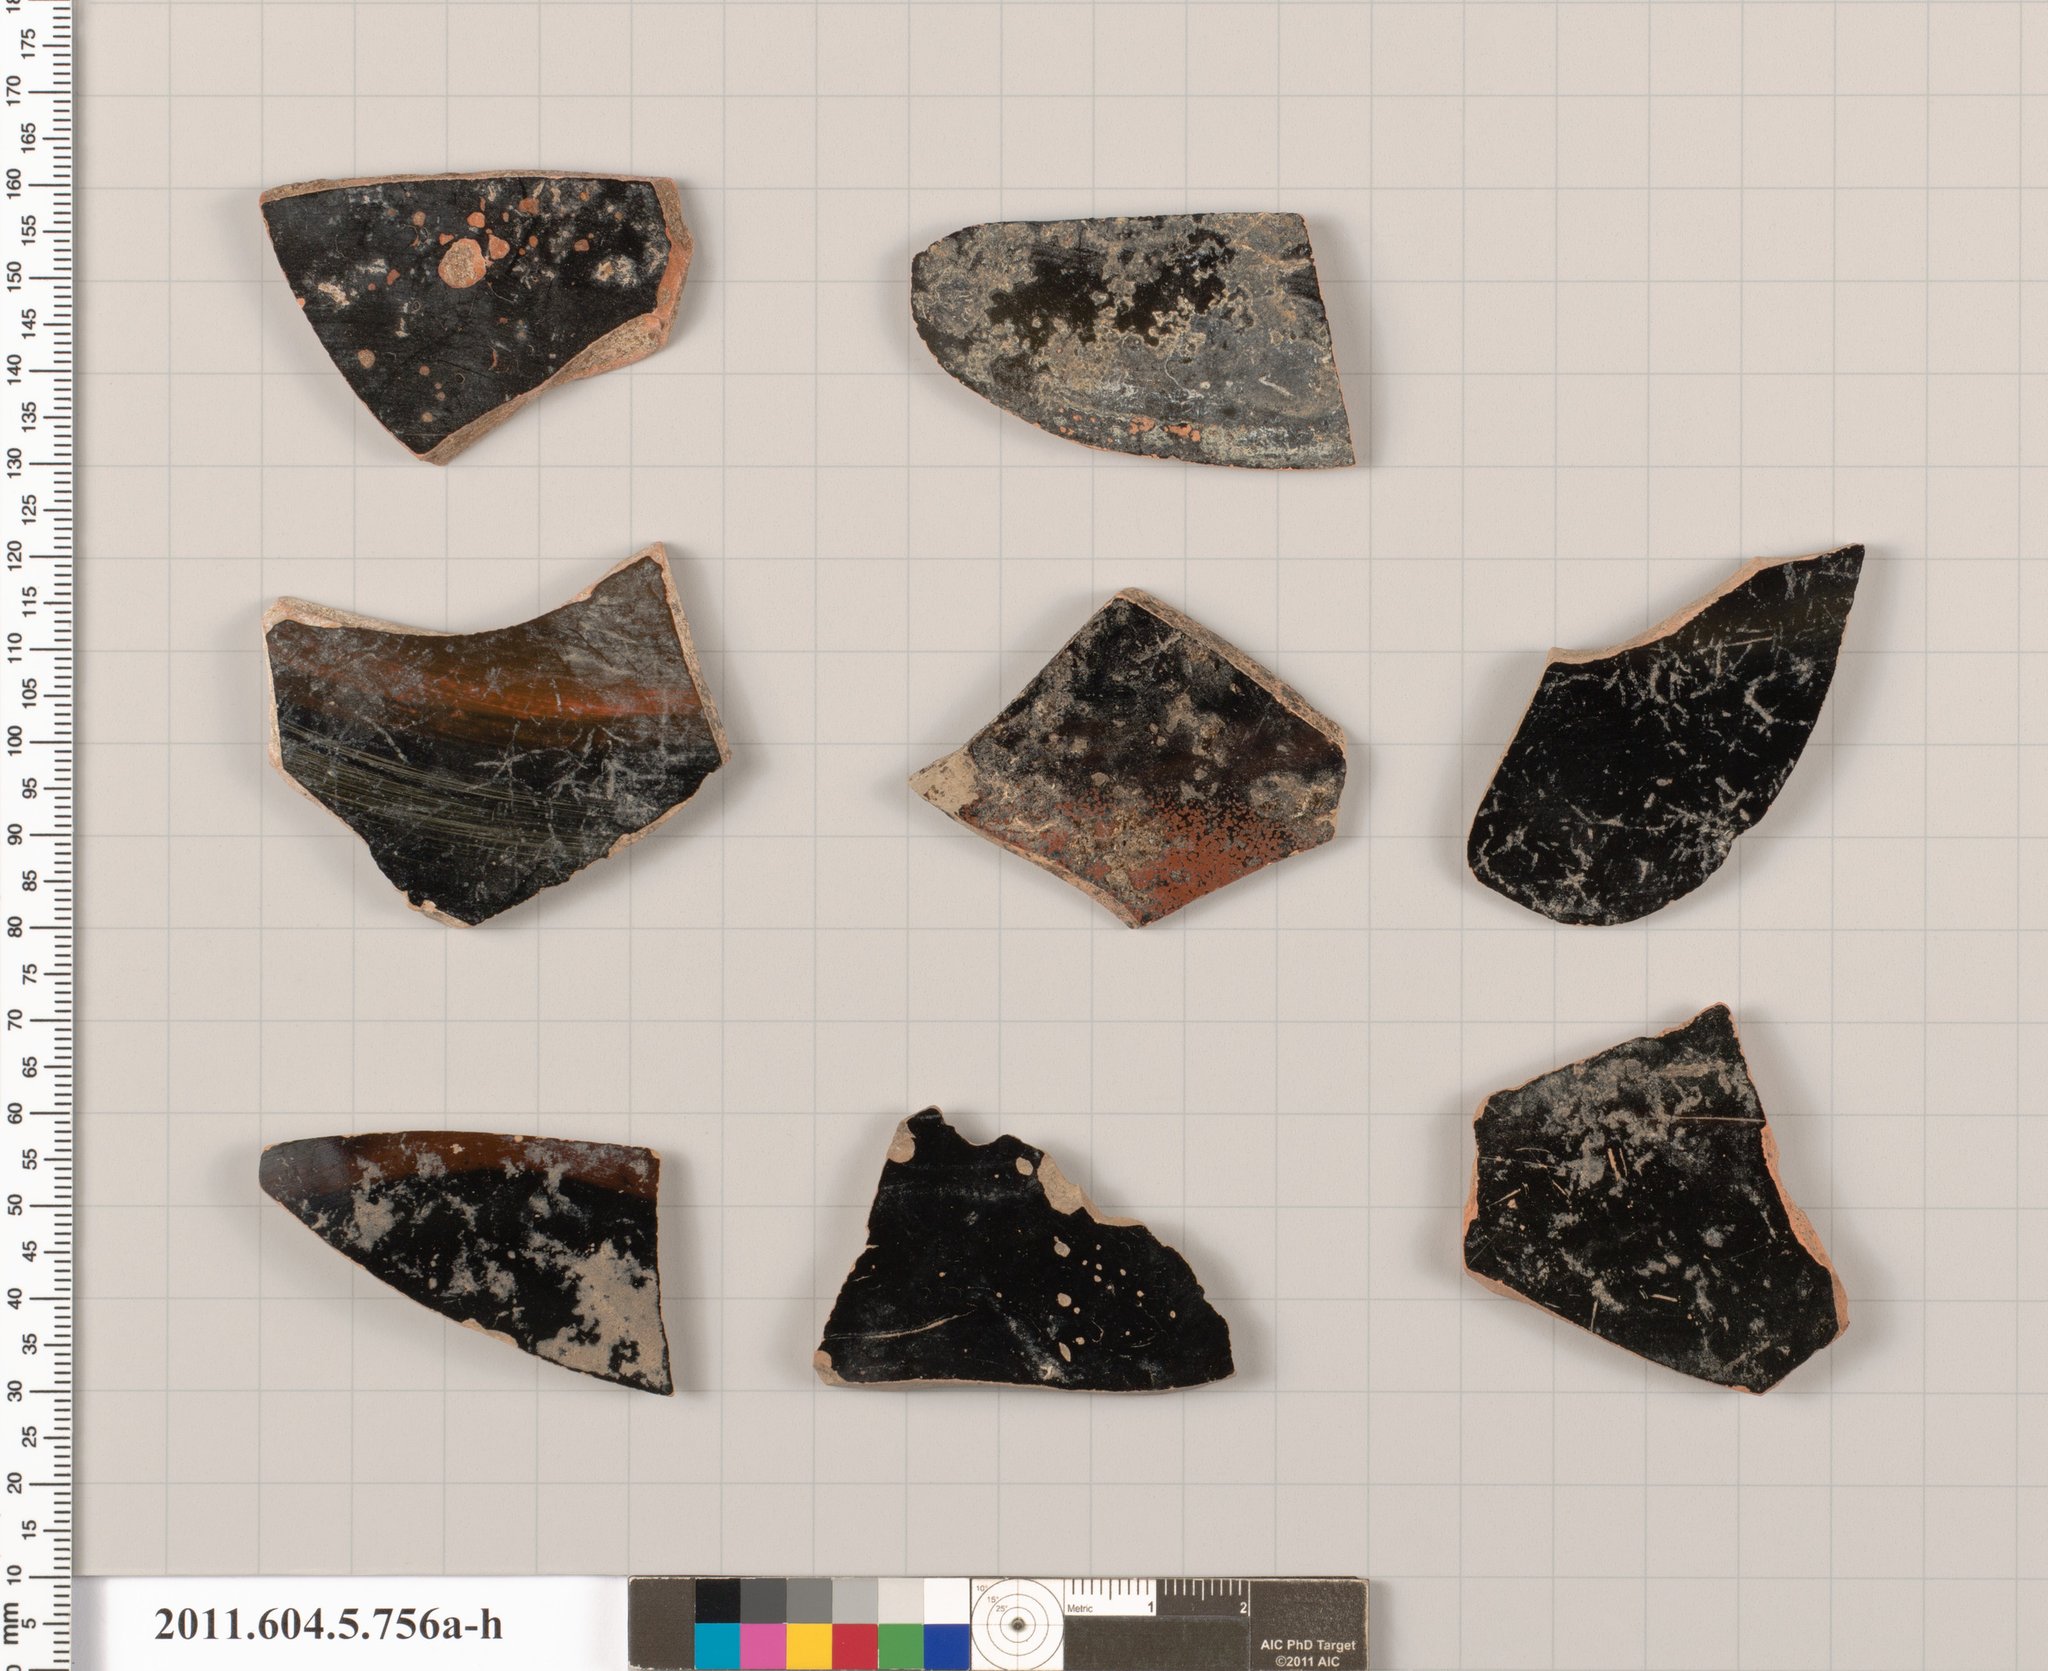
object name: kylix fragment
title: Terracotta fragments of kylikes (drinking cups)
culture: greek, attic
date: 600-401 BCE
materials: terracotta